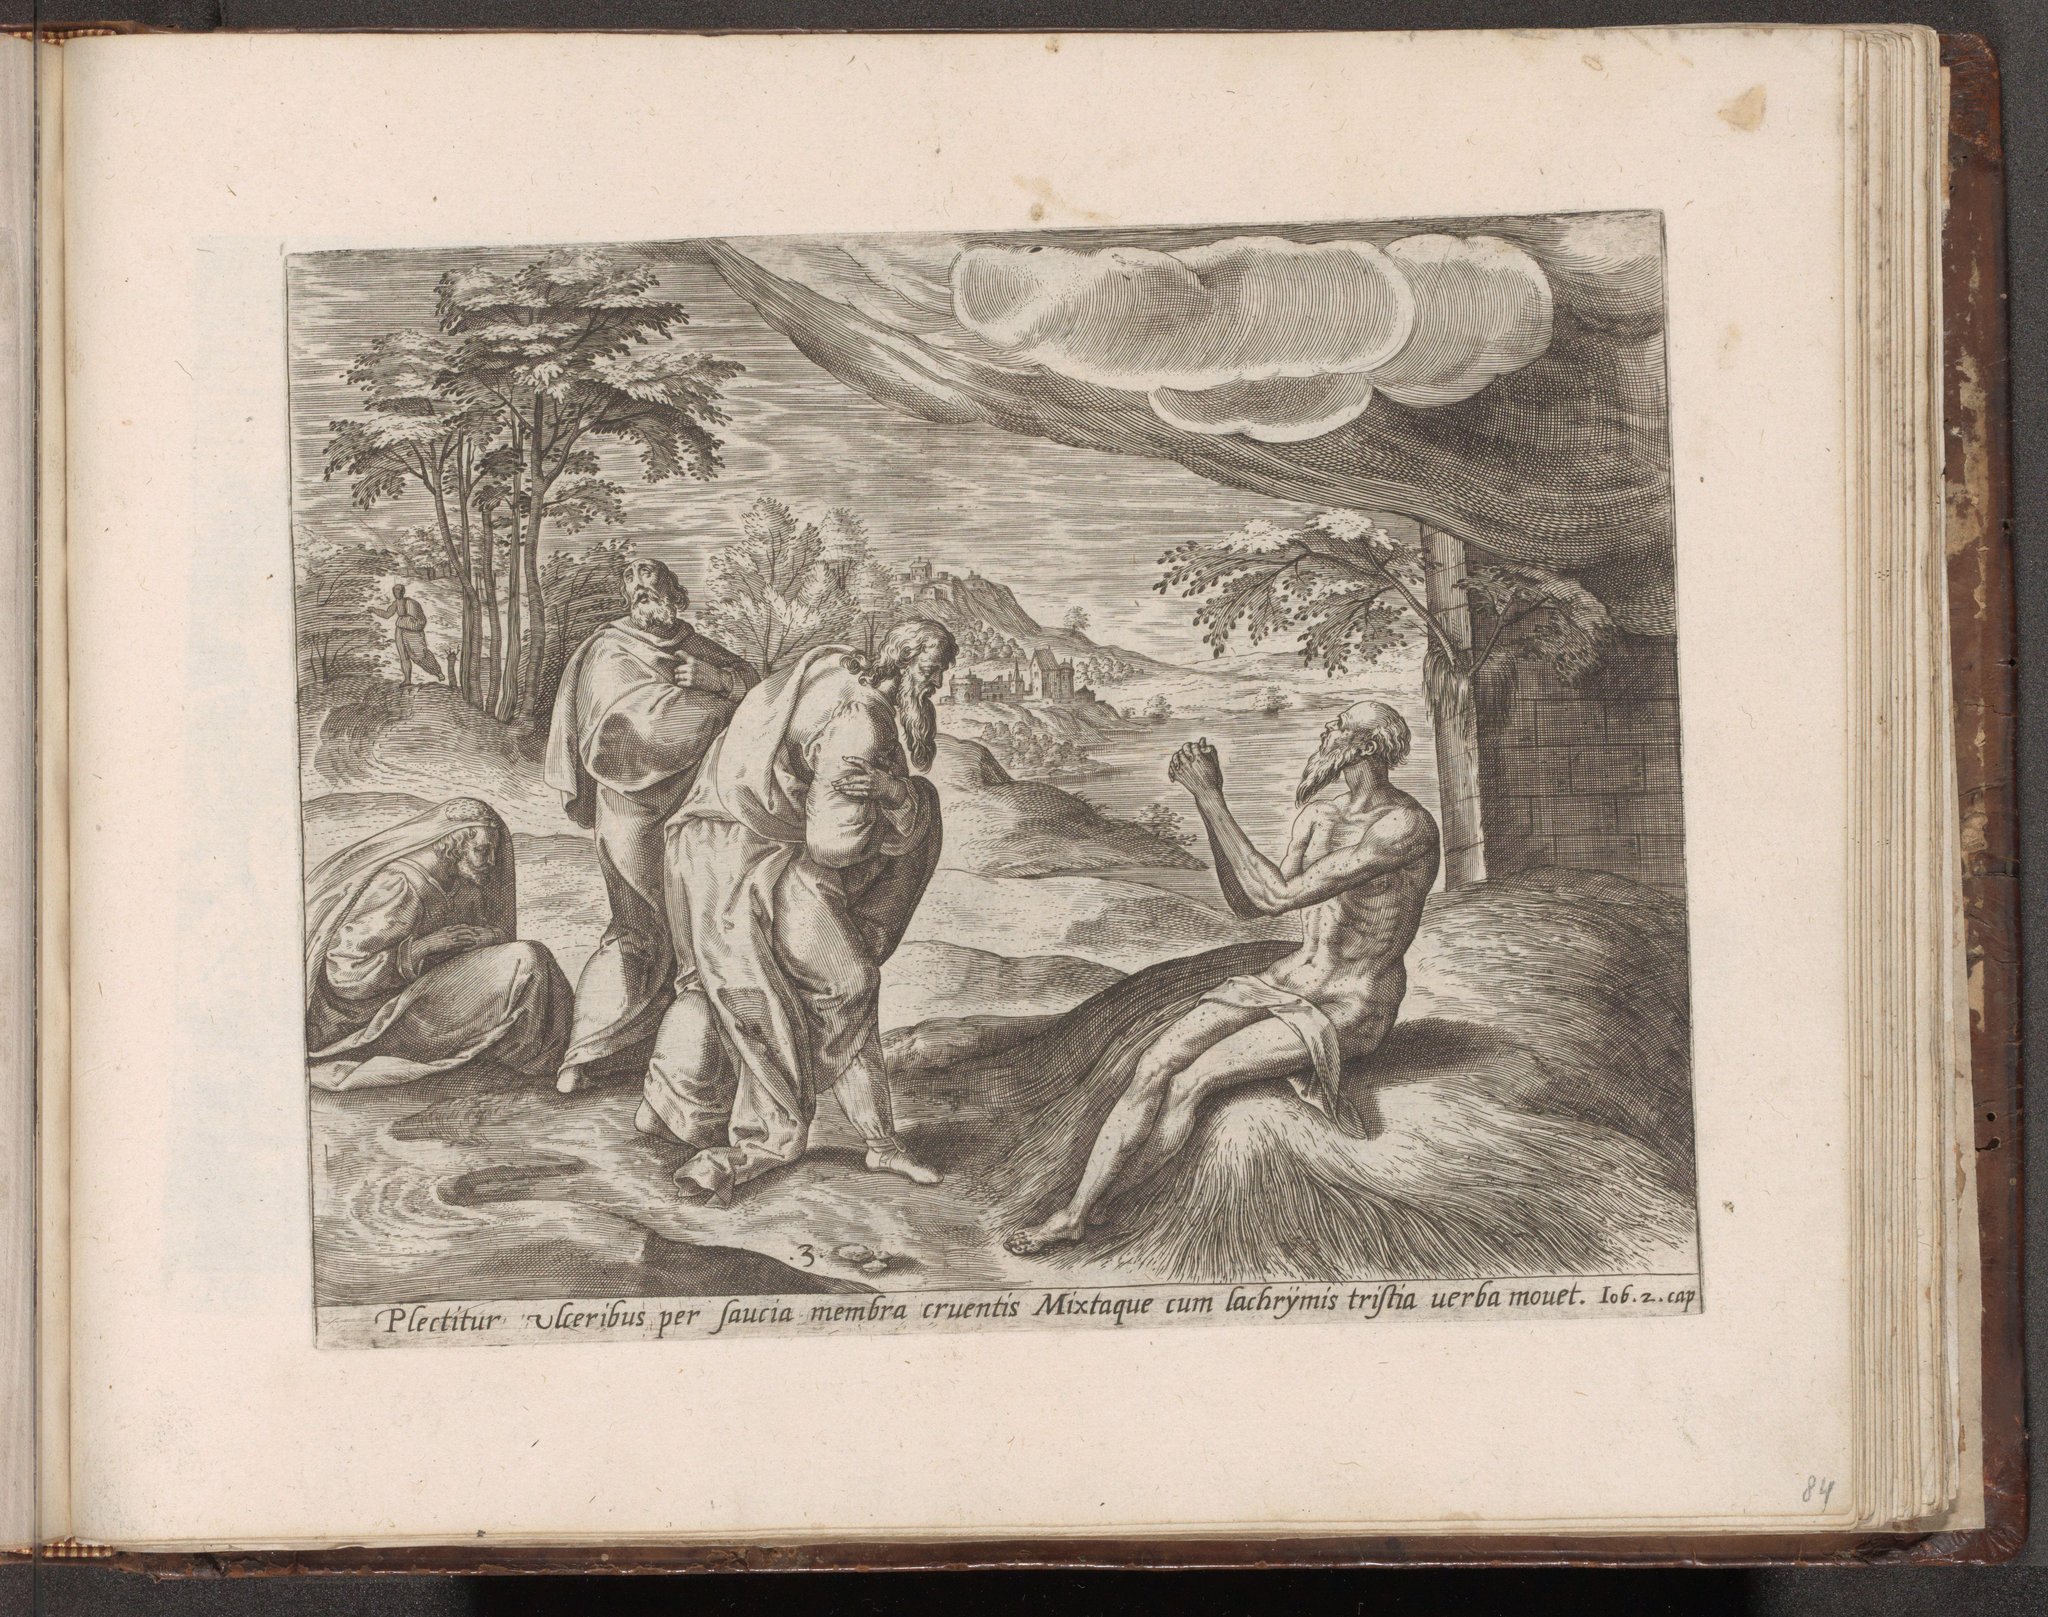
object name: album leaf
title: Historia Jobi (...)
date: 1579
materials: paper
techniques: engraving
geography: antwerp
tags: job on the dunghill visited by his friends (and wife)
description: Job zit op een mesthoop en wordt bezocht en bespot door zijn vrienden. Een van zijn vrienden zit in zak en as: hij heeft as op zijn hoofd gestrooid. Onder de voorstelling een verwijzing in het Latijn naar de Bijbeltekst in Job 2. Prent maakt deel uit van een album.